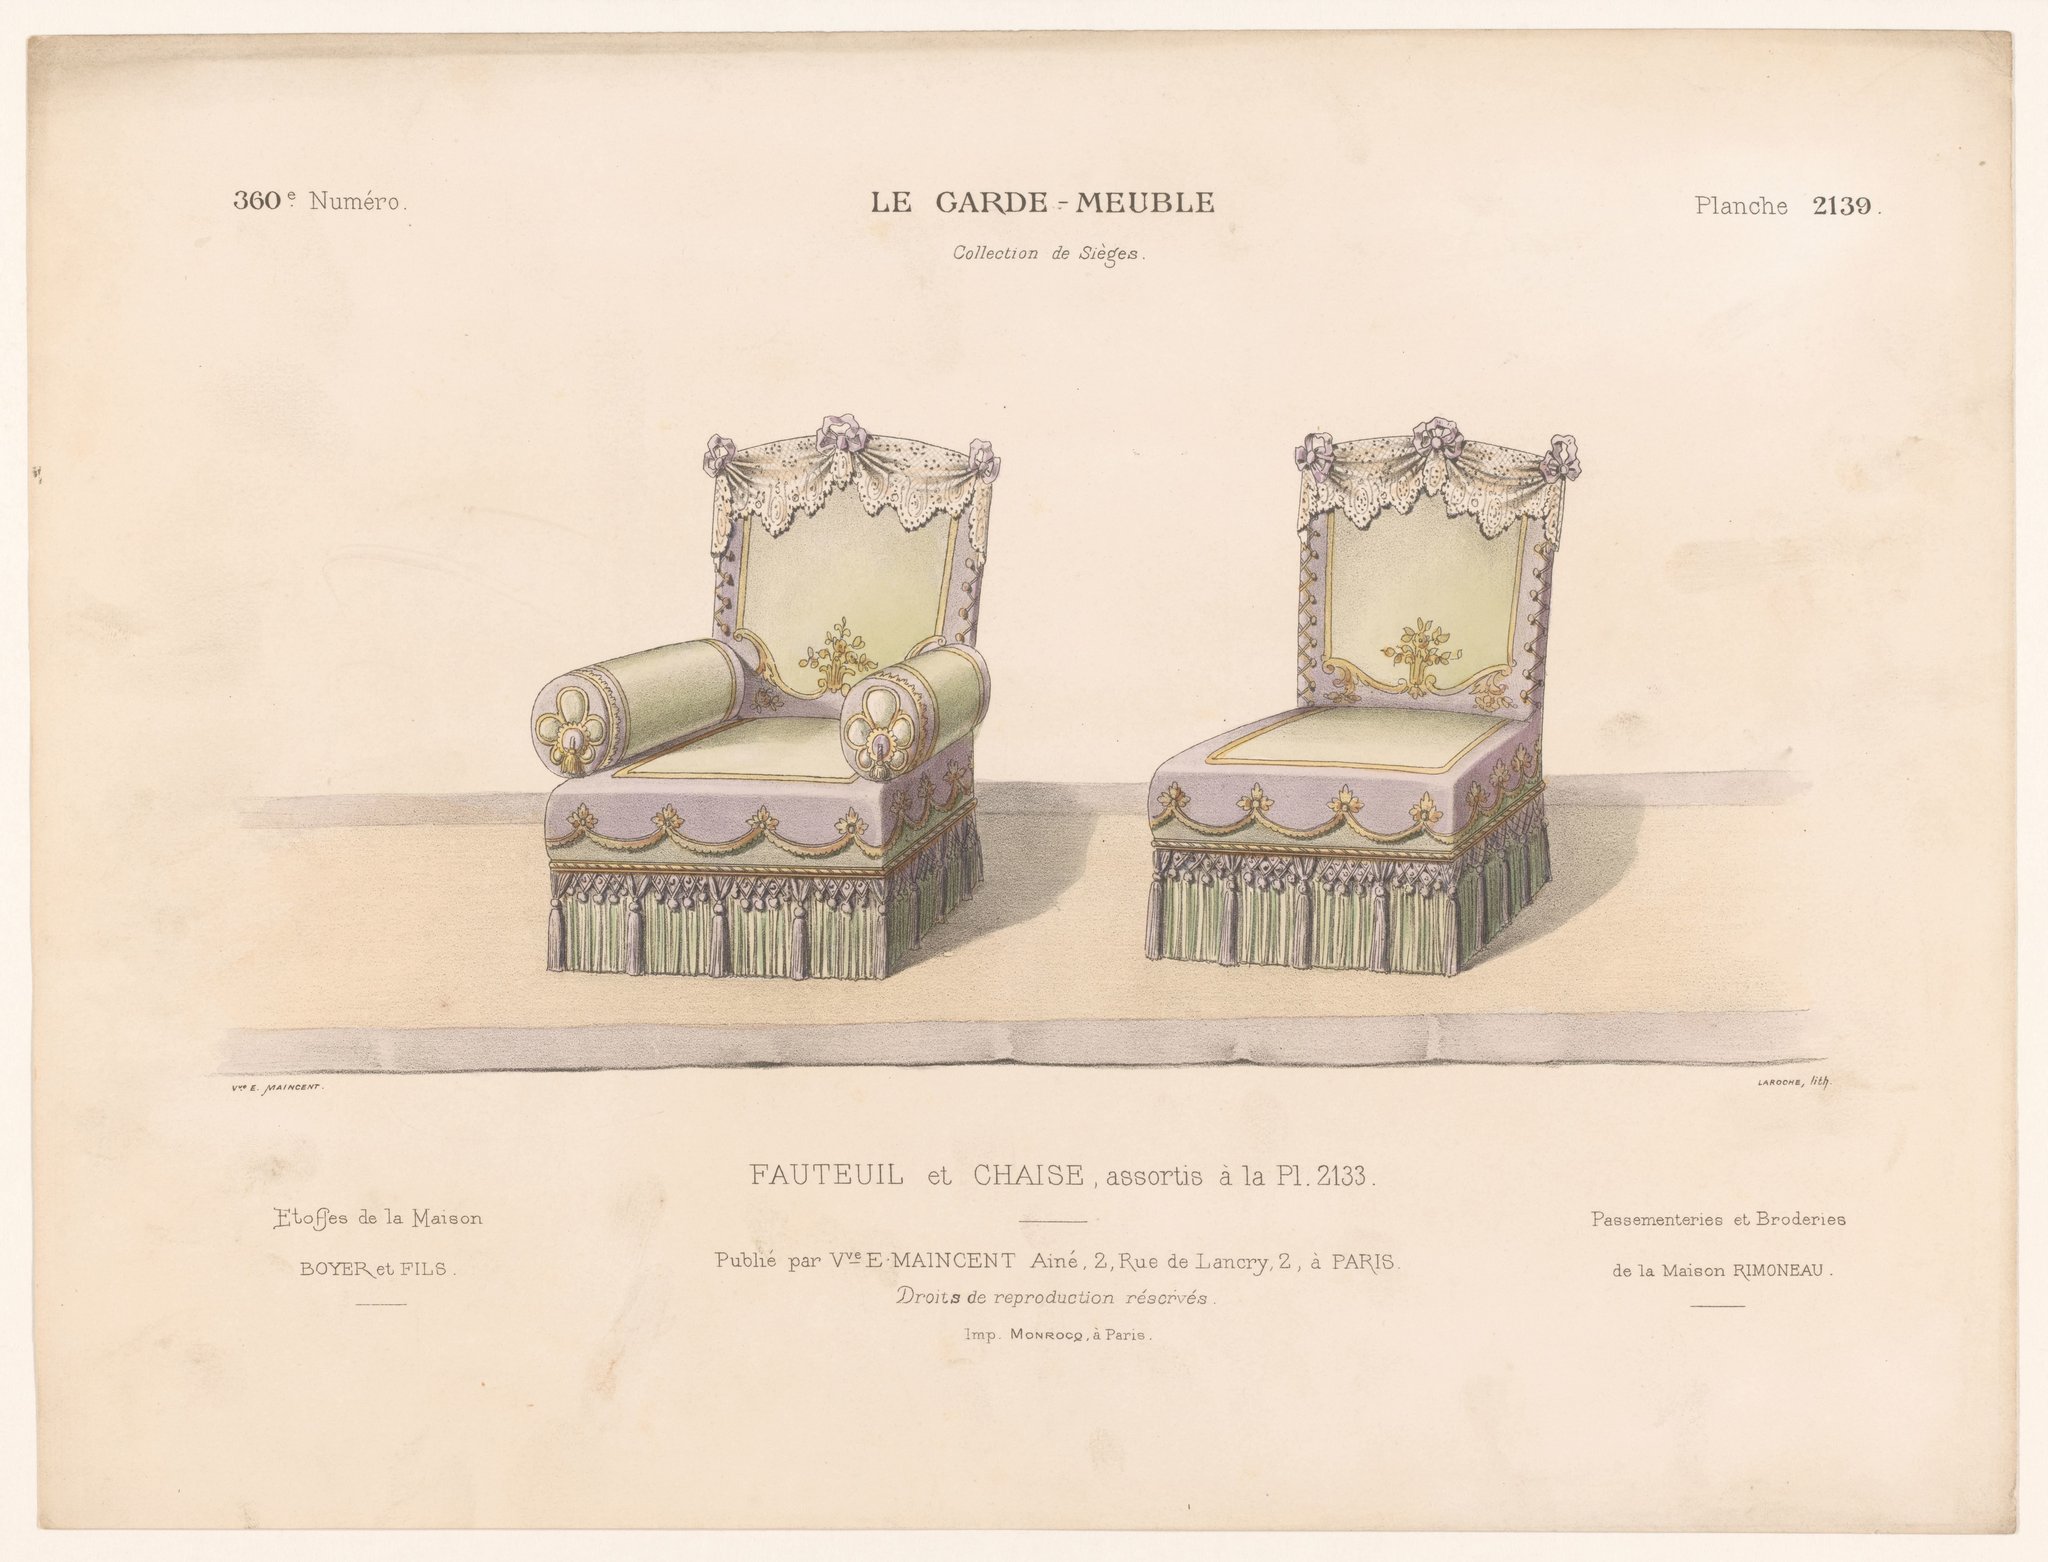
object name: print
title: Fauteuil et chaise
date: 1895-1935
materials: paper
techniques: hand coloring, lithograph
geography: paris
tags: seating furniture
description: Ieder Livraison in de serie Le Garde-Meuble bevat negen platen: drie 'sièges' (zitmeubels), drie 'meubles' (diverse meubels zoals tafels en kasten) en drie 'tentures' (gordijnen en draperieën).